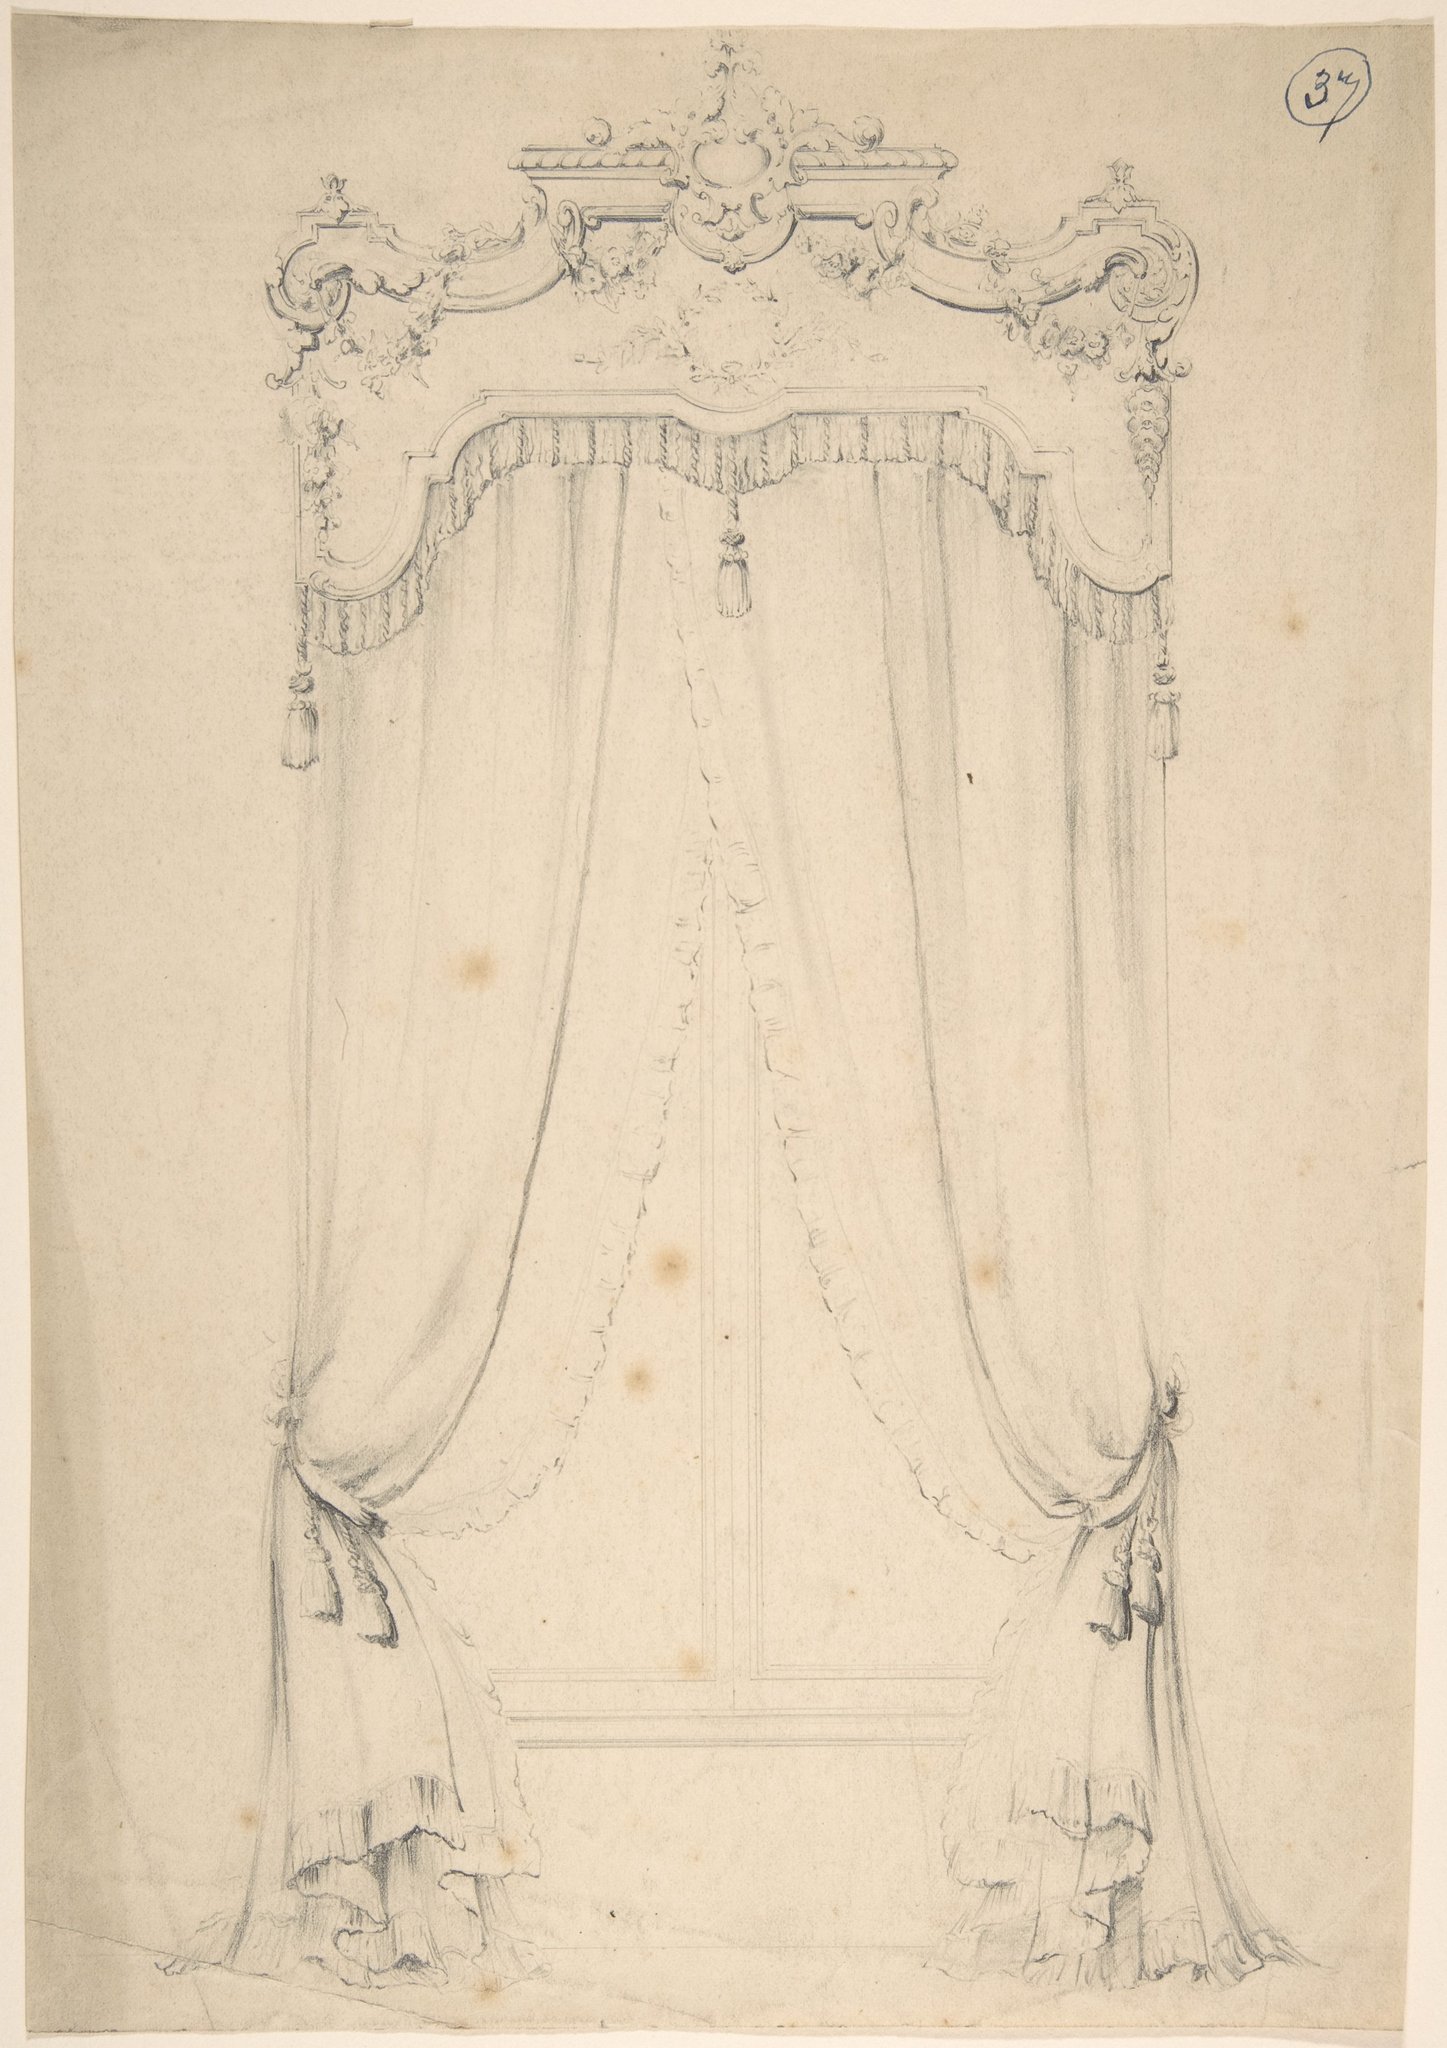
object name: drawing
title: Design for Curtains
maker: charles hindley and sons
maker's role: artist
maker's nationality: british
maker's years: 1841-1917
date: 1841-1900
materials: graphite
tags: curtains